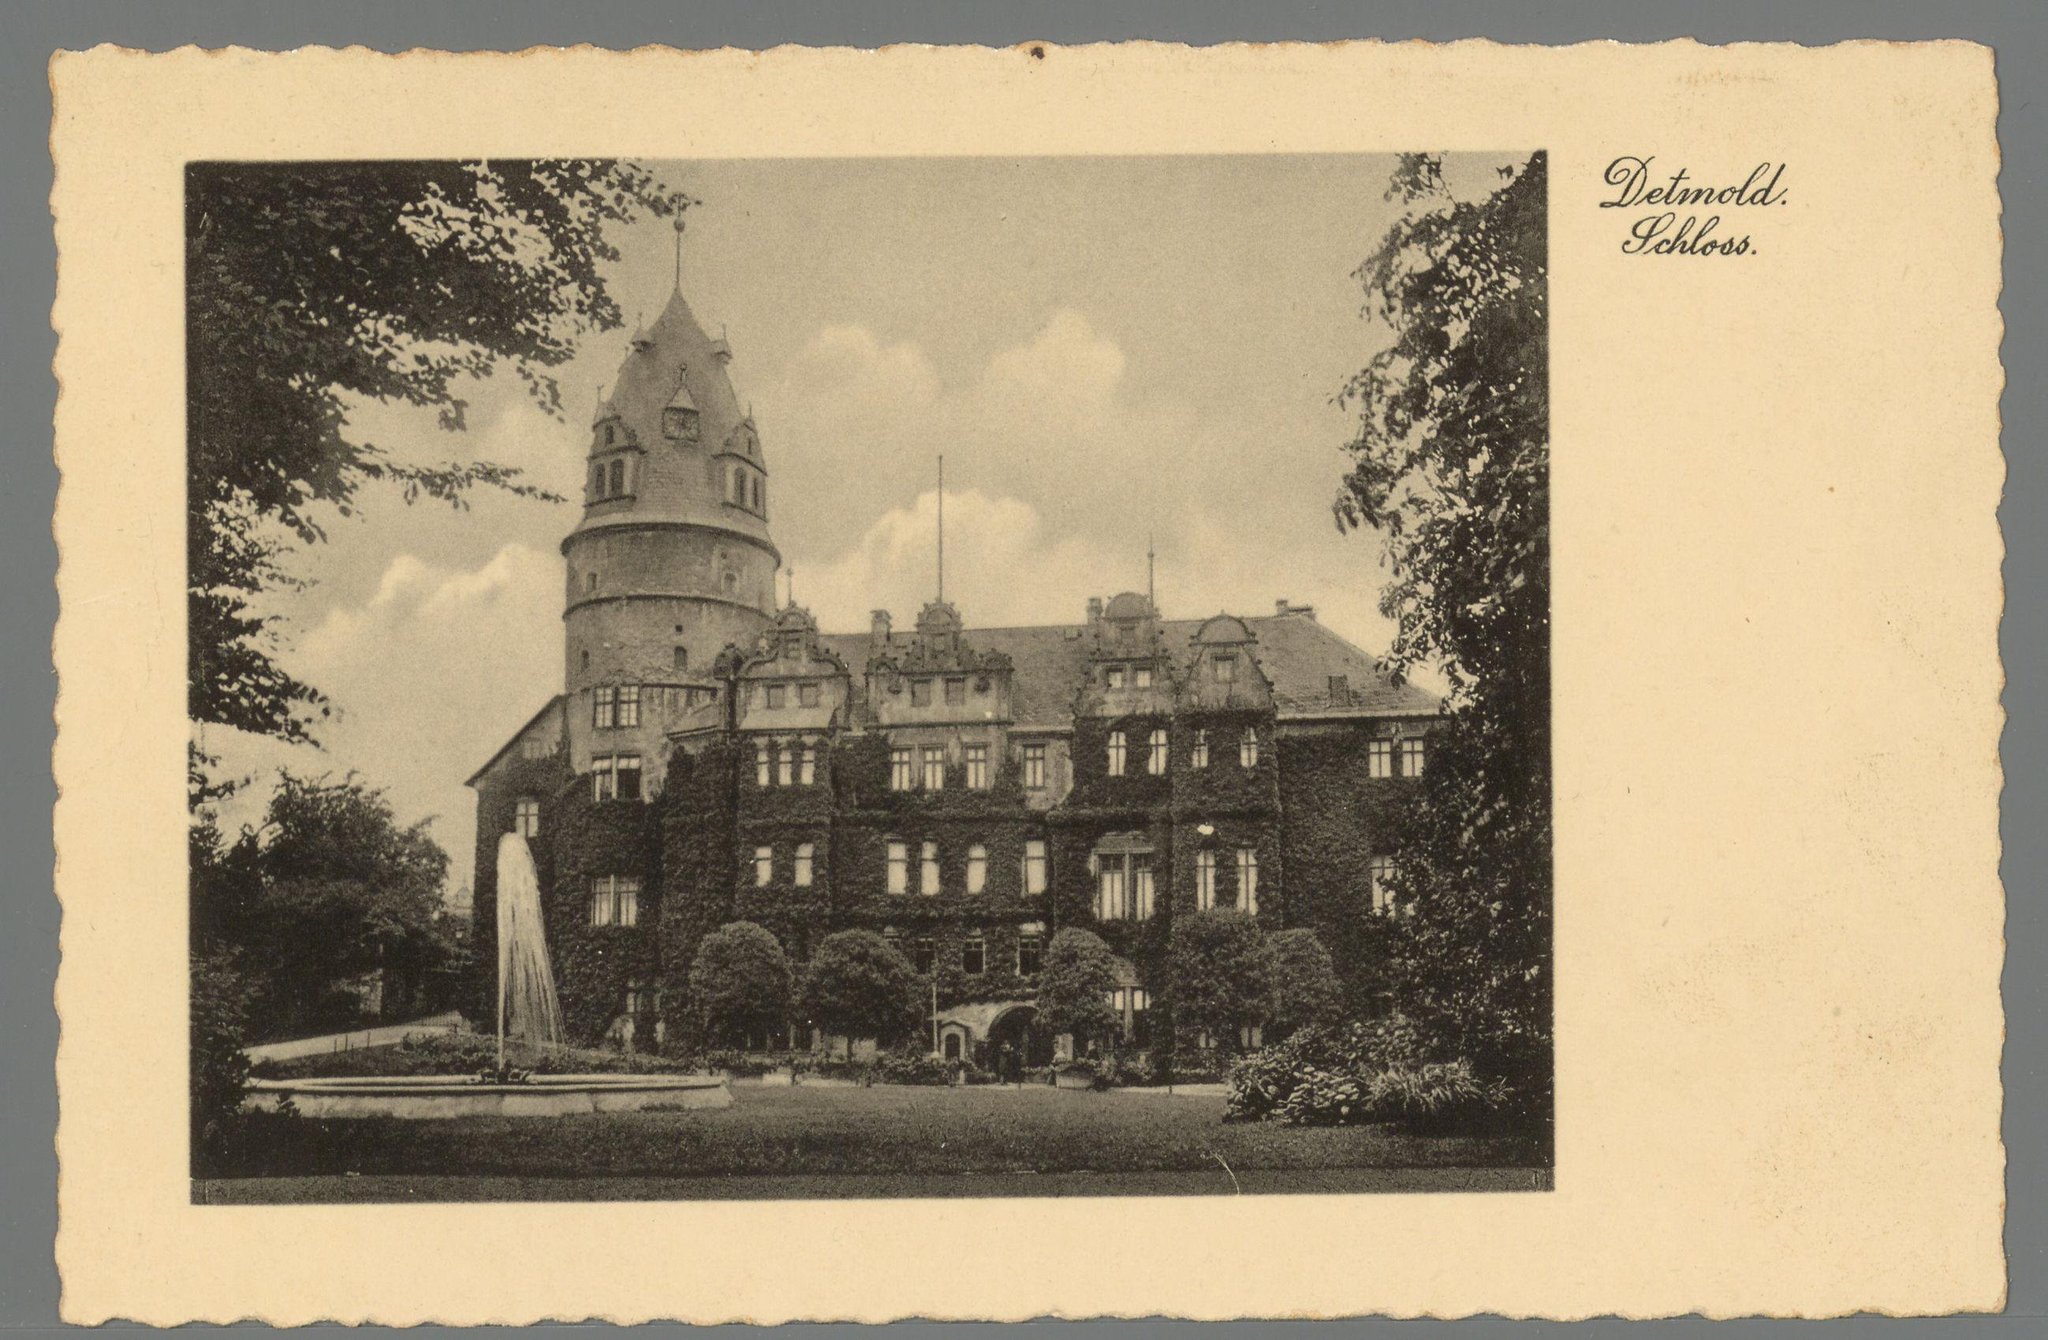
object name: photomechanical print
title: Detmold. Schloss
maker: Anonymous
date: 1905-1930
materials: cardboard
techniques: photograph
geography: hannover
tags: castle